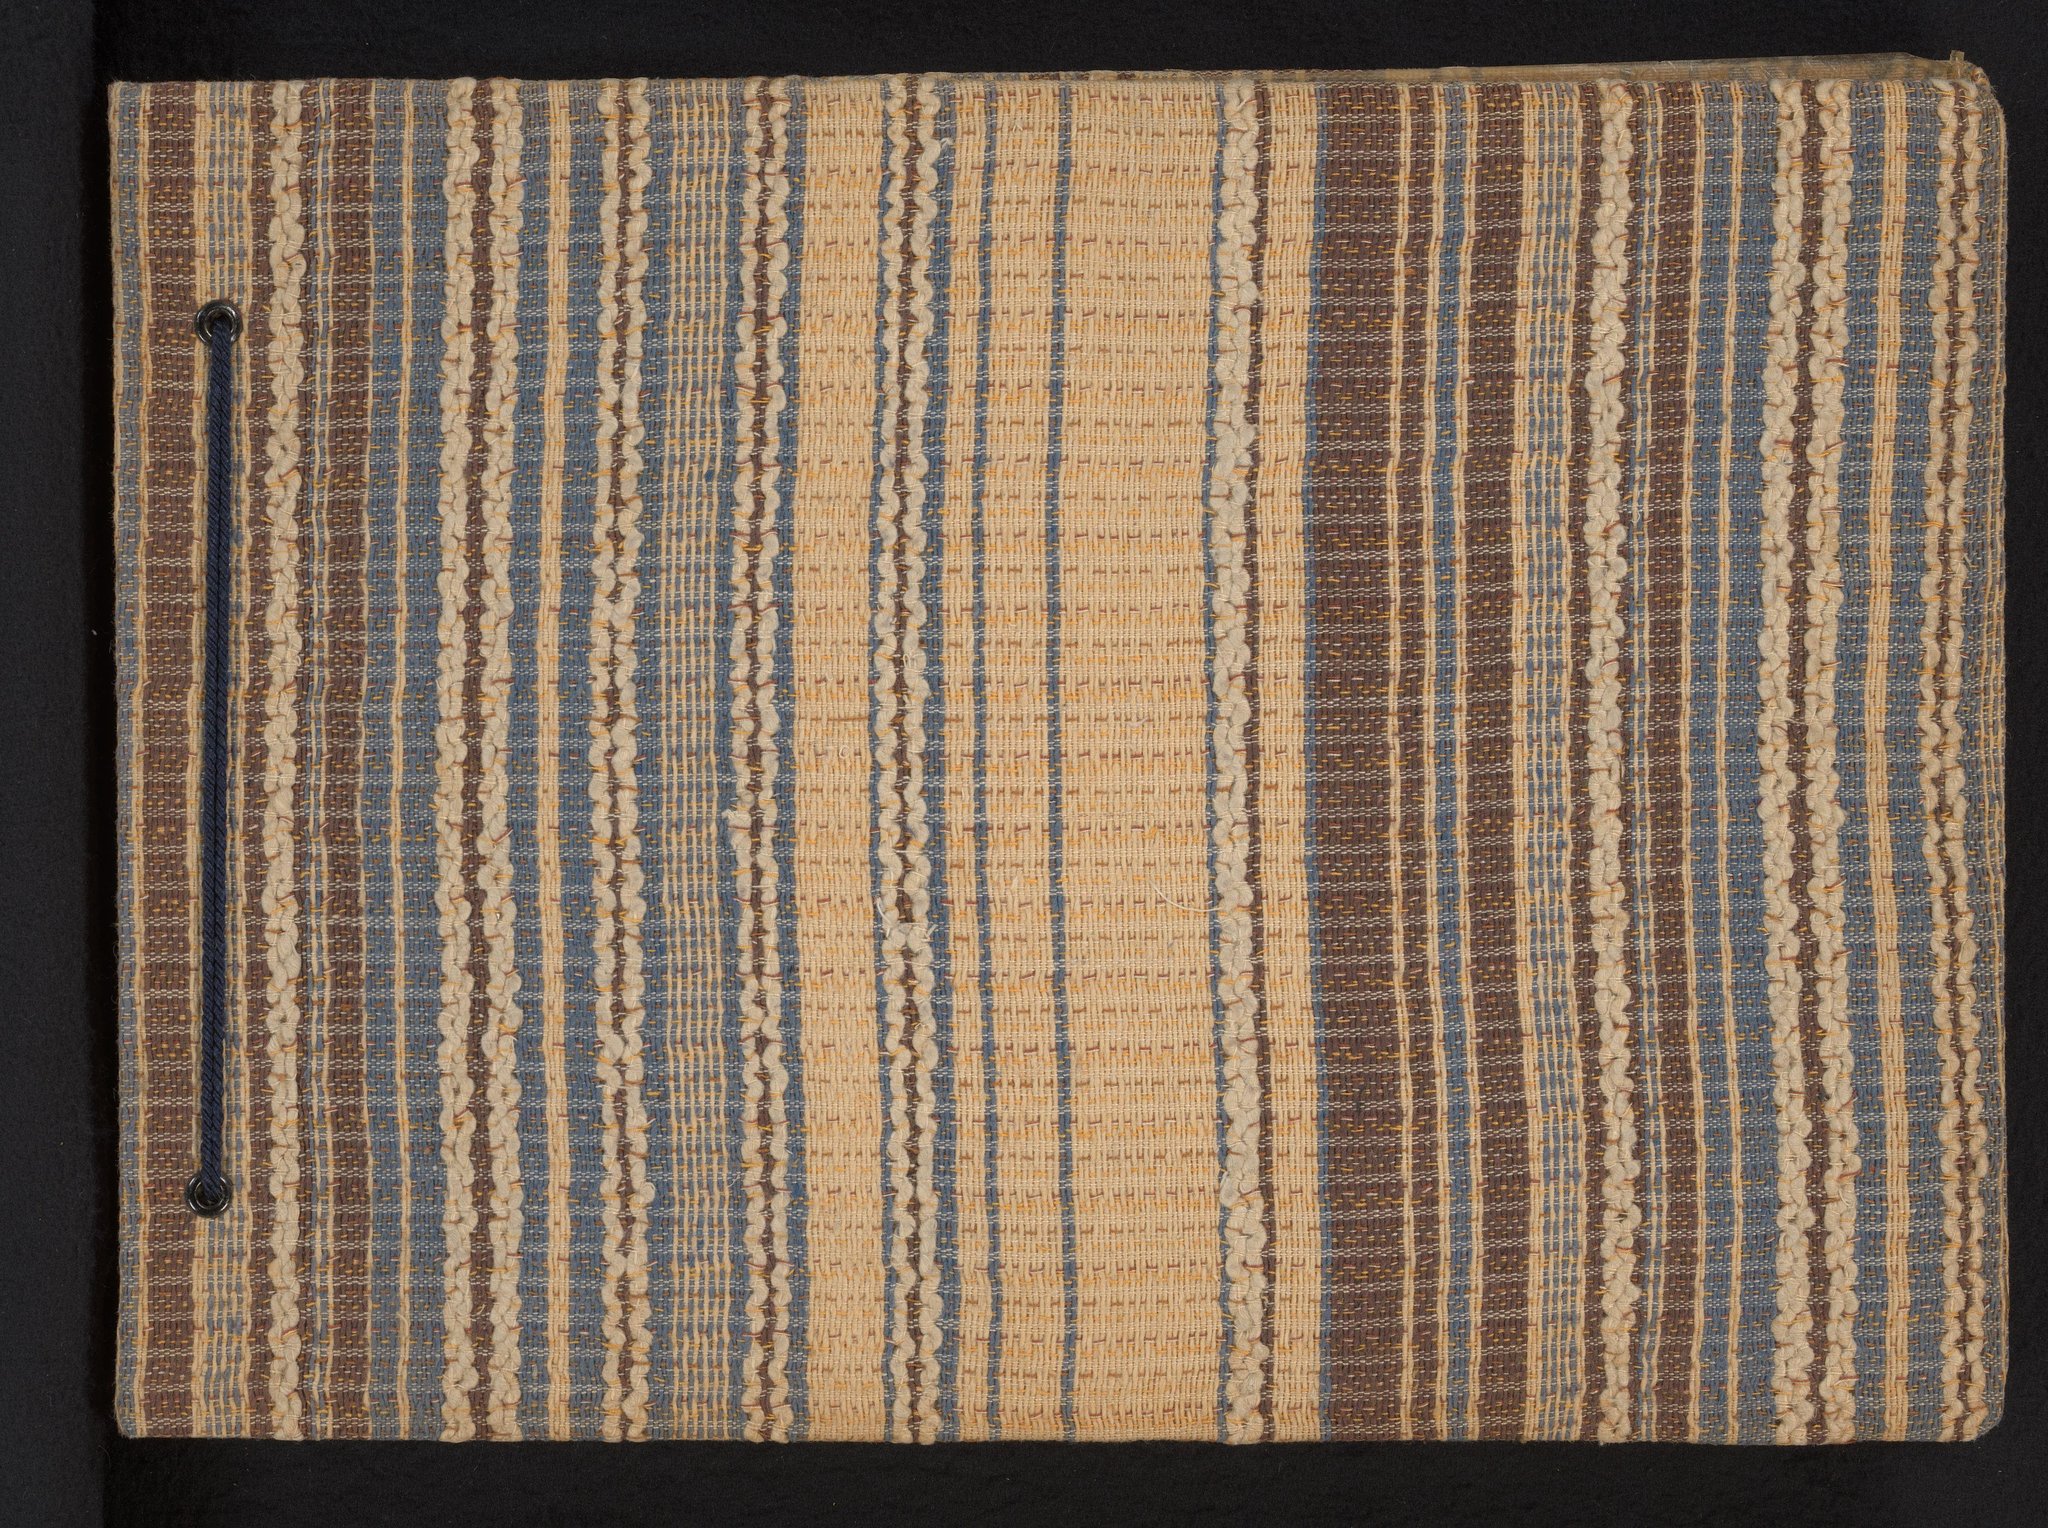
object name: photograph album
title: Vakantietripjes rondom de Tweede Wereldoorlog (album 1)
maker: Anonymous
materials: paper, photographic support, textile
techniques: gelatin silver print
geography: luxembourg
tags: netherlands, rhenen, the hague, delft, middelburg, den bosch, nijmegen, grave, maastricht, bergen op zoom, arnhem, belgium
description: Album met stoffen omslag met verticale strepen in beige, bruin en blauw. Met 24 albumbladen van bruin karton met in totaal 113 zwart-wit foto's. Opnames van drie verschillende vakanties. 1) Trektocht van vader en zoon (?) op de fiets van 10 t/m 23 september 1939 door Nederland: Ootmarsum, Hardenberg, Coevorden, Exloo, Ruinen, Borger, Rolde, Giethoorn, Hasselt, Wezep, Nunspeet, Soestdijk, Bussum. 2) Trektocht per fiets van 6 t/m 13 juli 1940 en een autotrip met het gezin door Nederland, België en Luxemburg in juni 1949. door Nederland: Rhenen, Grebbeberg, Arnhem, Nijmegen, Grave, Sint Oedenrode, Breda, Bergen op Zoom, Goes, Middelburg, Nieuwland, Oosterschelde, Halsteren, Standdaarbuiten, Zevenbergen, Moerdijkbrug, Delft, Den Hoorn, De Lier, Hoek van Holland, Monster, 's-Gravenhage. 3) Vakantie met de auto door Nederland, België en Luxemburg van 18 t/m 25 juni 1949: Valkenburg, Heerlen, Malmédy, Ardennen, Vianden, Clervaux, Verviers, Slenaken, Vaals, Drielandenpunt, Maastricht, St. Pietersberg, Brunssum, Oirschot, 's-Hertogenbosch, Beek, Renkum, kasteel Doorwerth, Rozendaal, Zutphen, Almelo. Onder de foto's ingeplakte getypte onderschriften op strookjes papier.